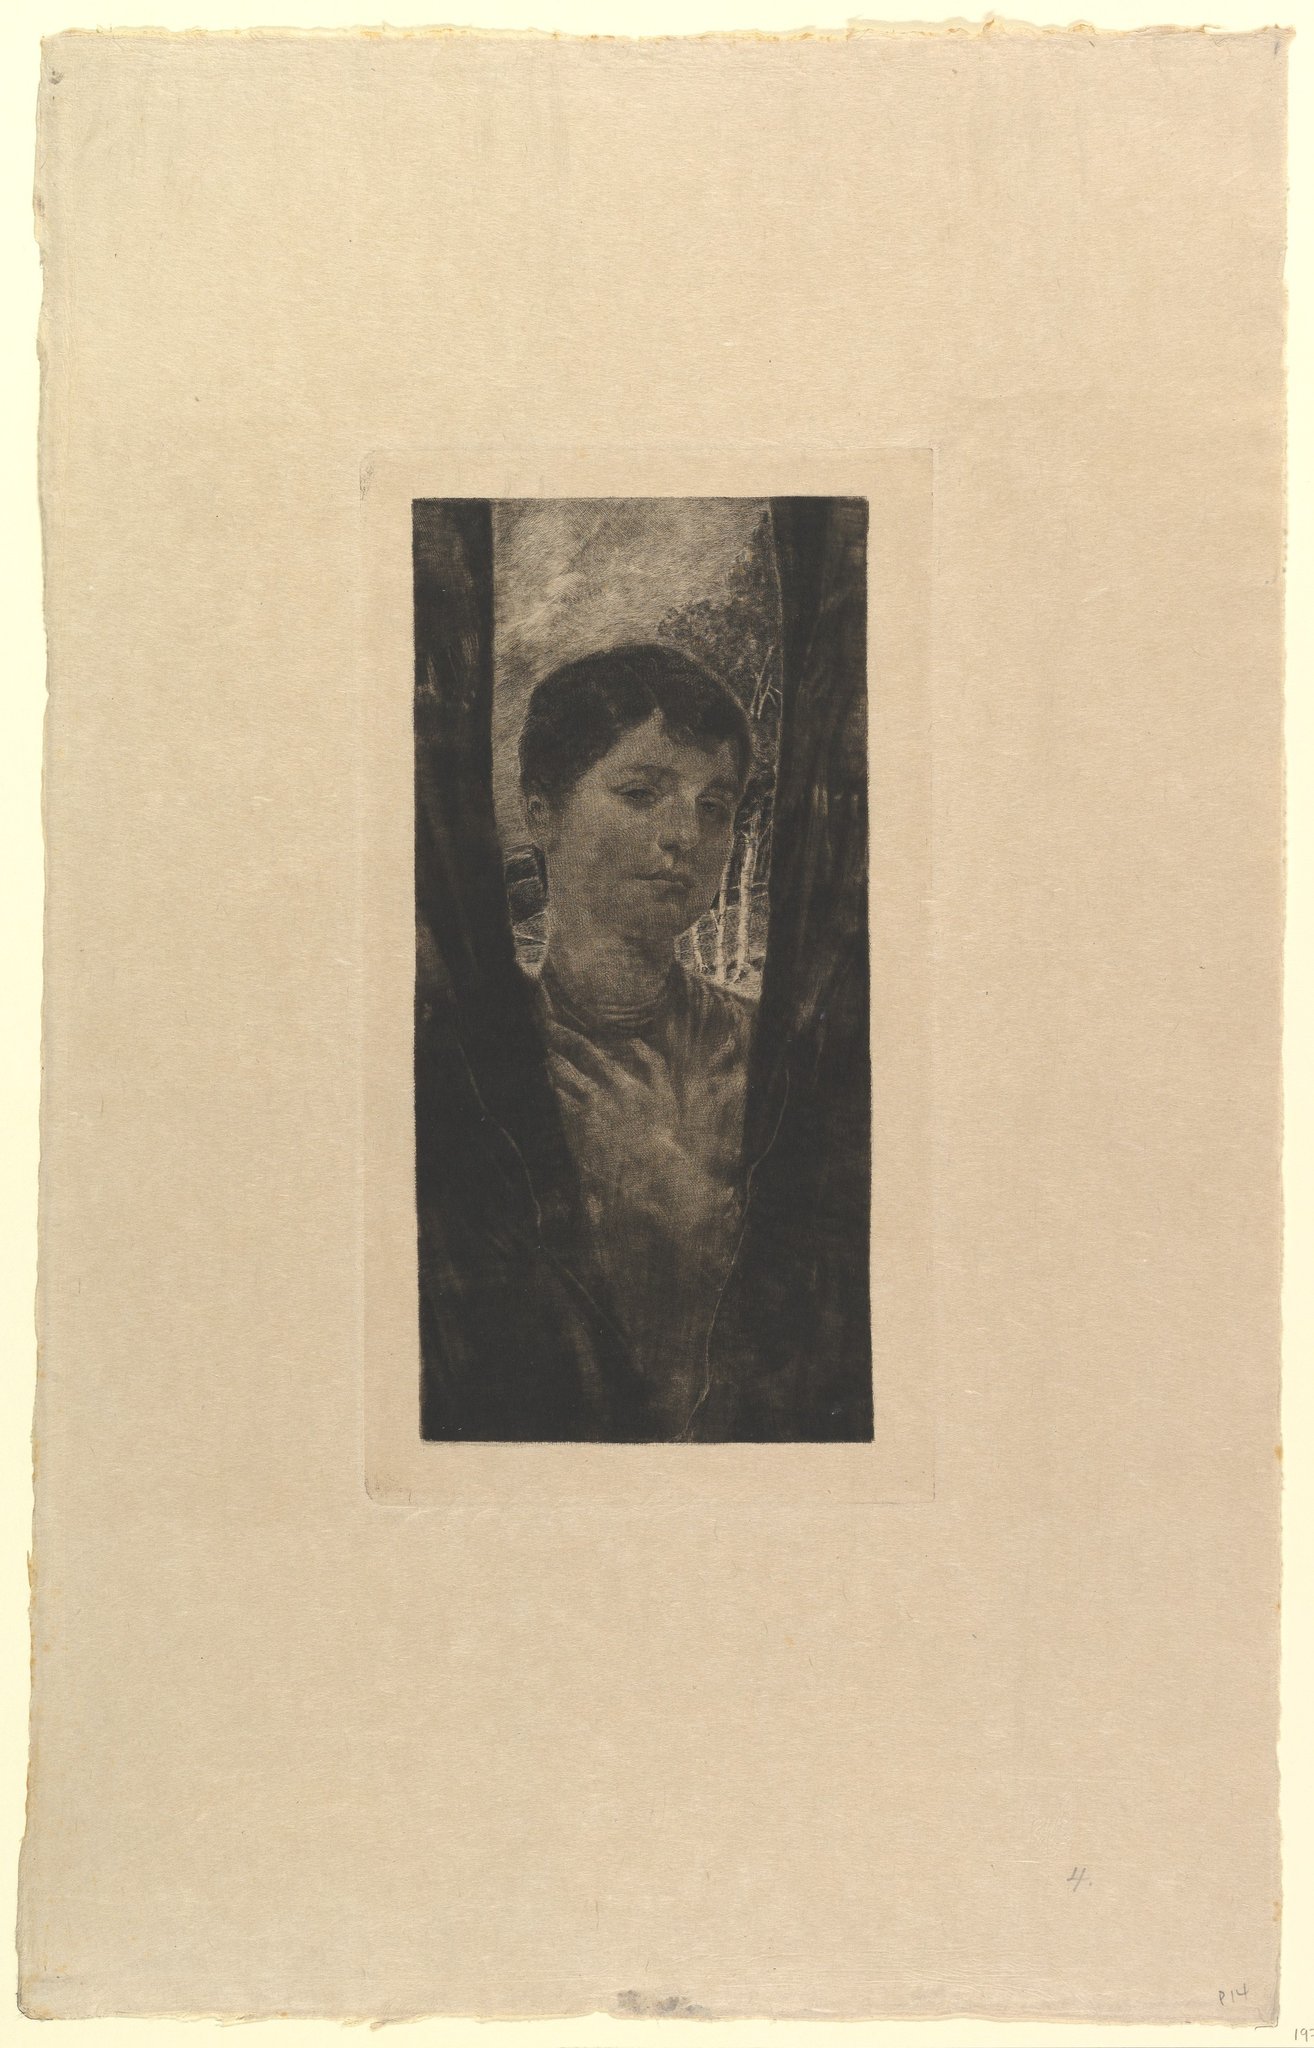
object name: print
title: Die Ferngeliebte (Errinerung) Verworfene Platte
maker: max klinger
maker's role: artist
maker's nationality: german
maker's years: 1857-1920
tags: portraits,women